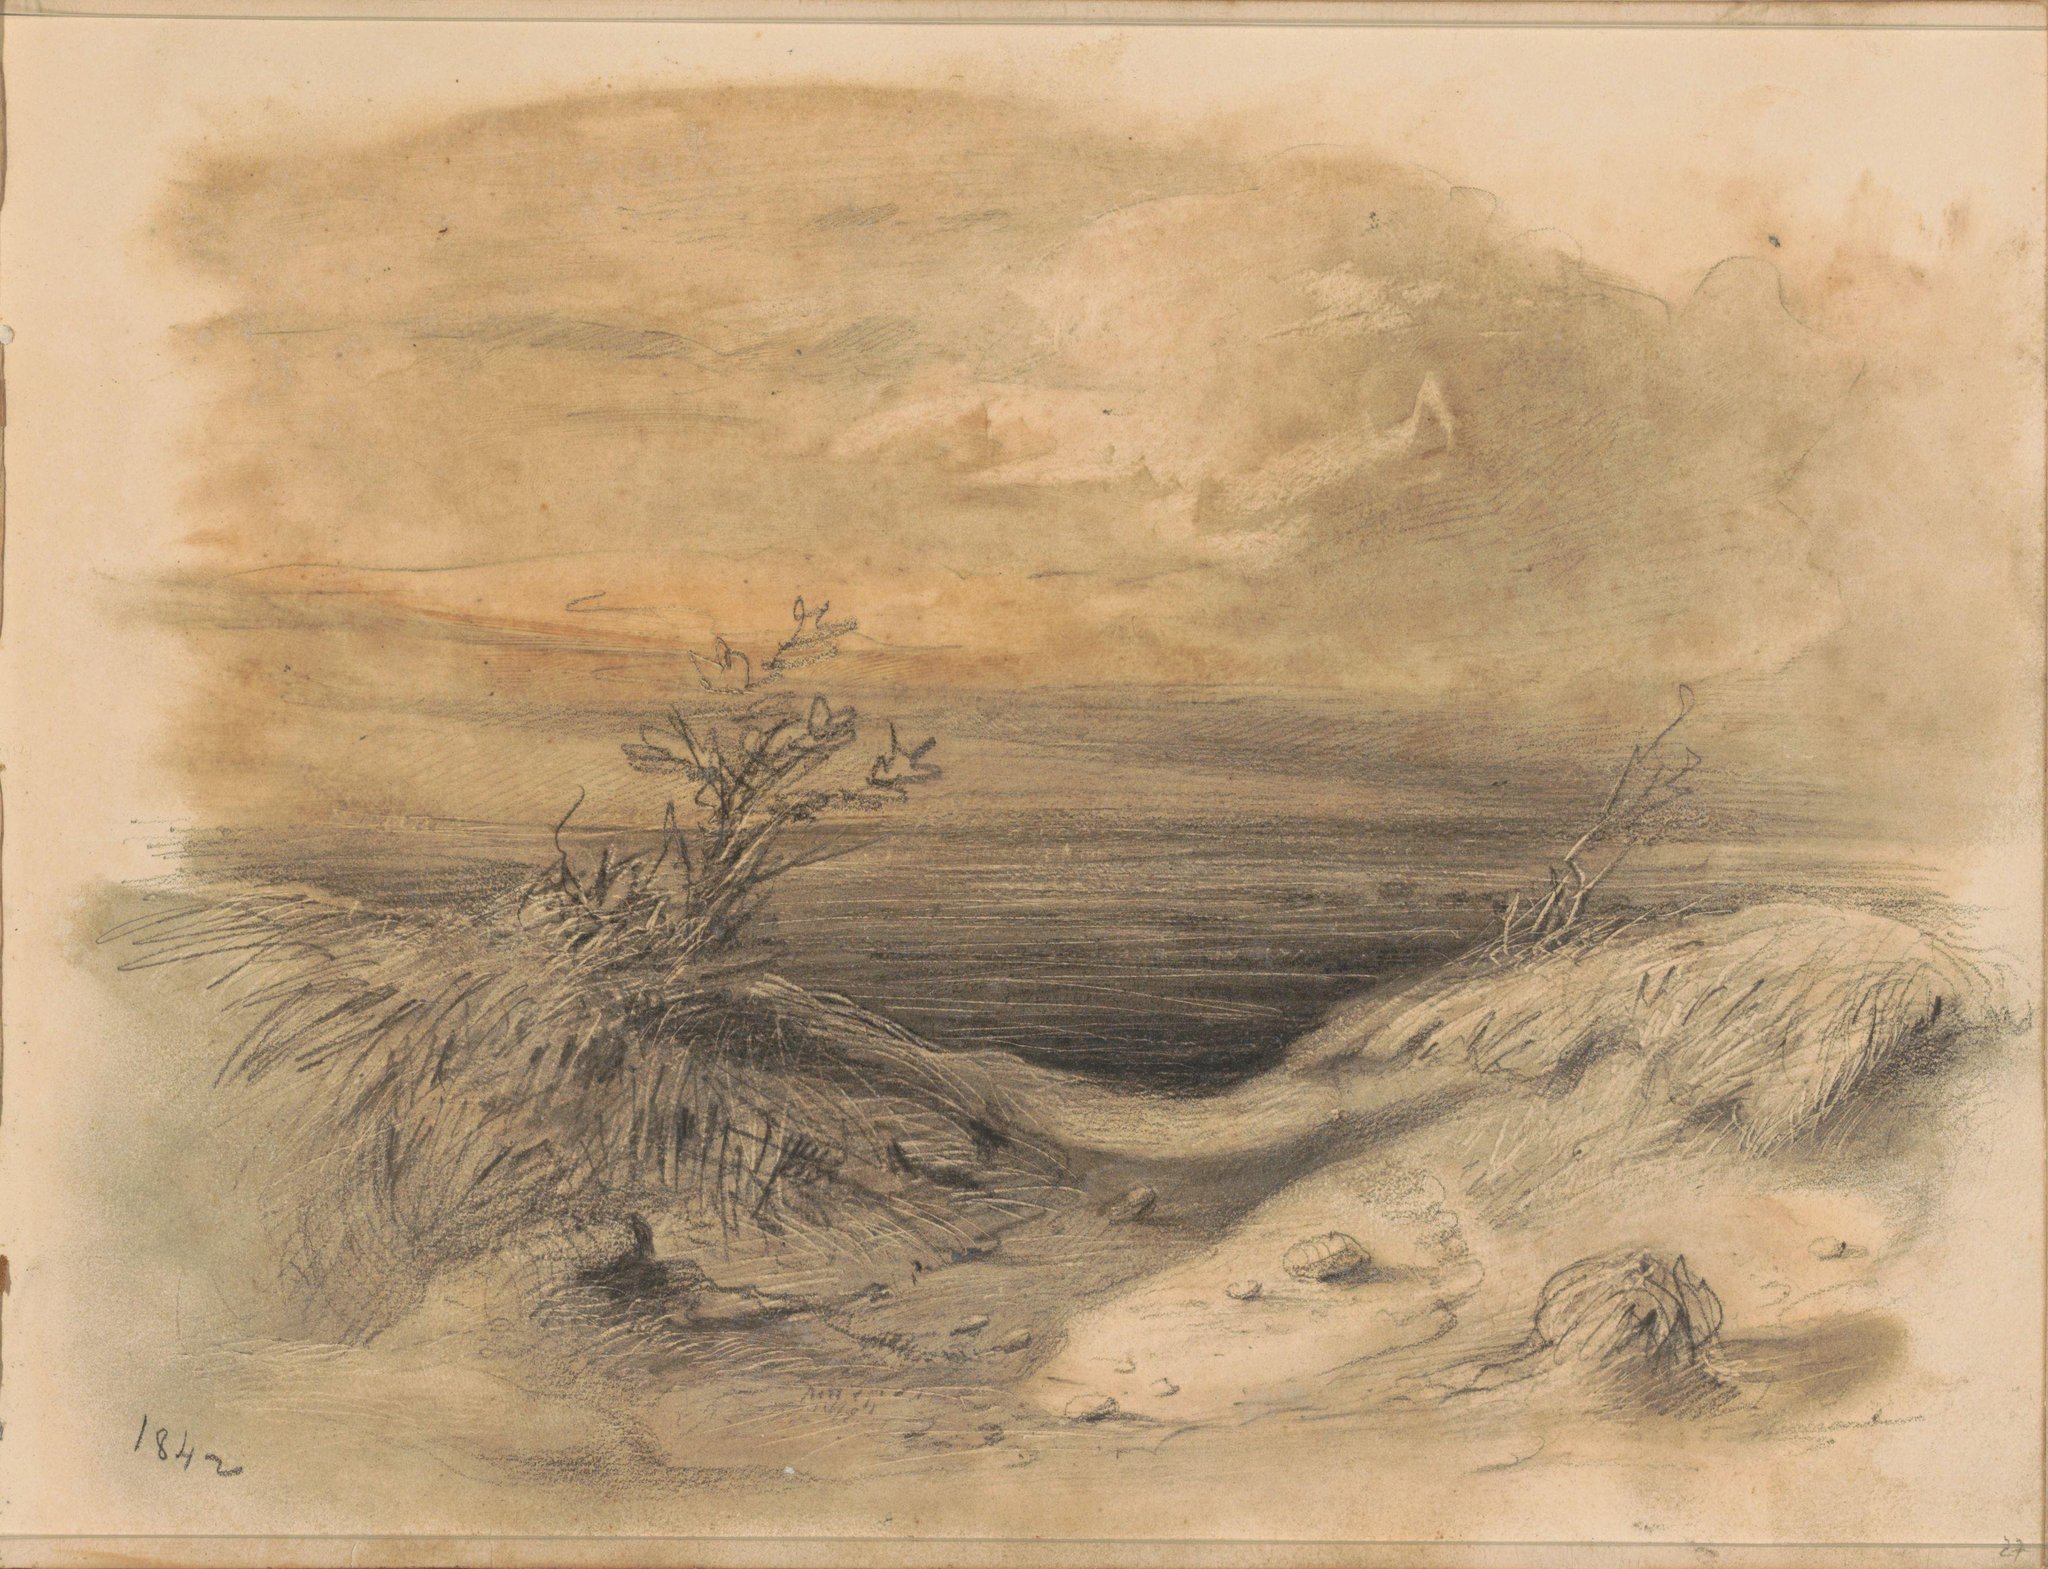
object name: sketchbook leaf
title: Heidelandschap met bomen en keien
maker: johannes tavenraat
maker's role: draughtsman, painter, print maker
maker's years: 1809-1881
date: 1842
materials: chalk, paper, pencil, watercolor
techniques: brush, scoring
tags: trees, landscapes, boulder, stone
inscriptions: date: ‘1842’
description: Blad 27 recto uit een schetsboek met 43 bladen.